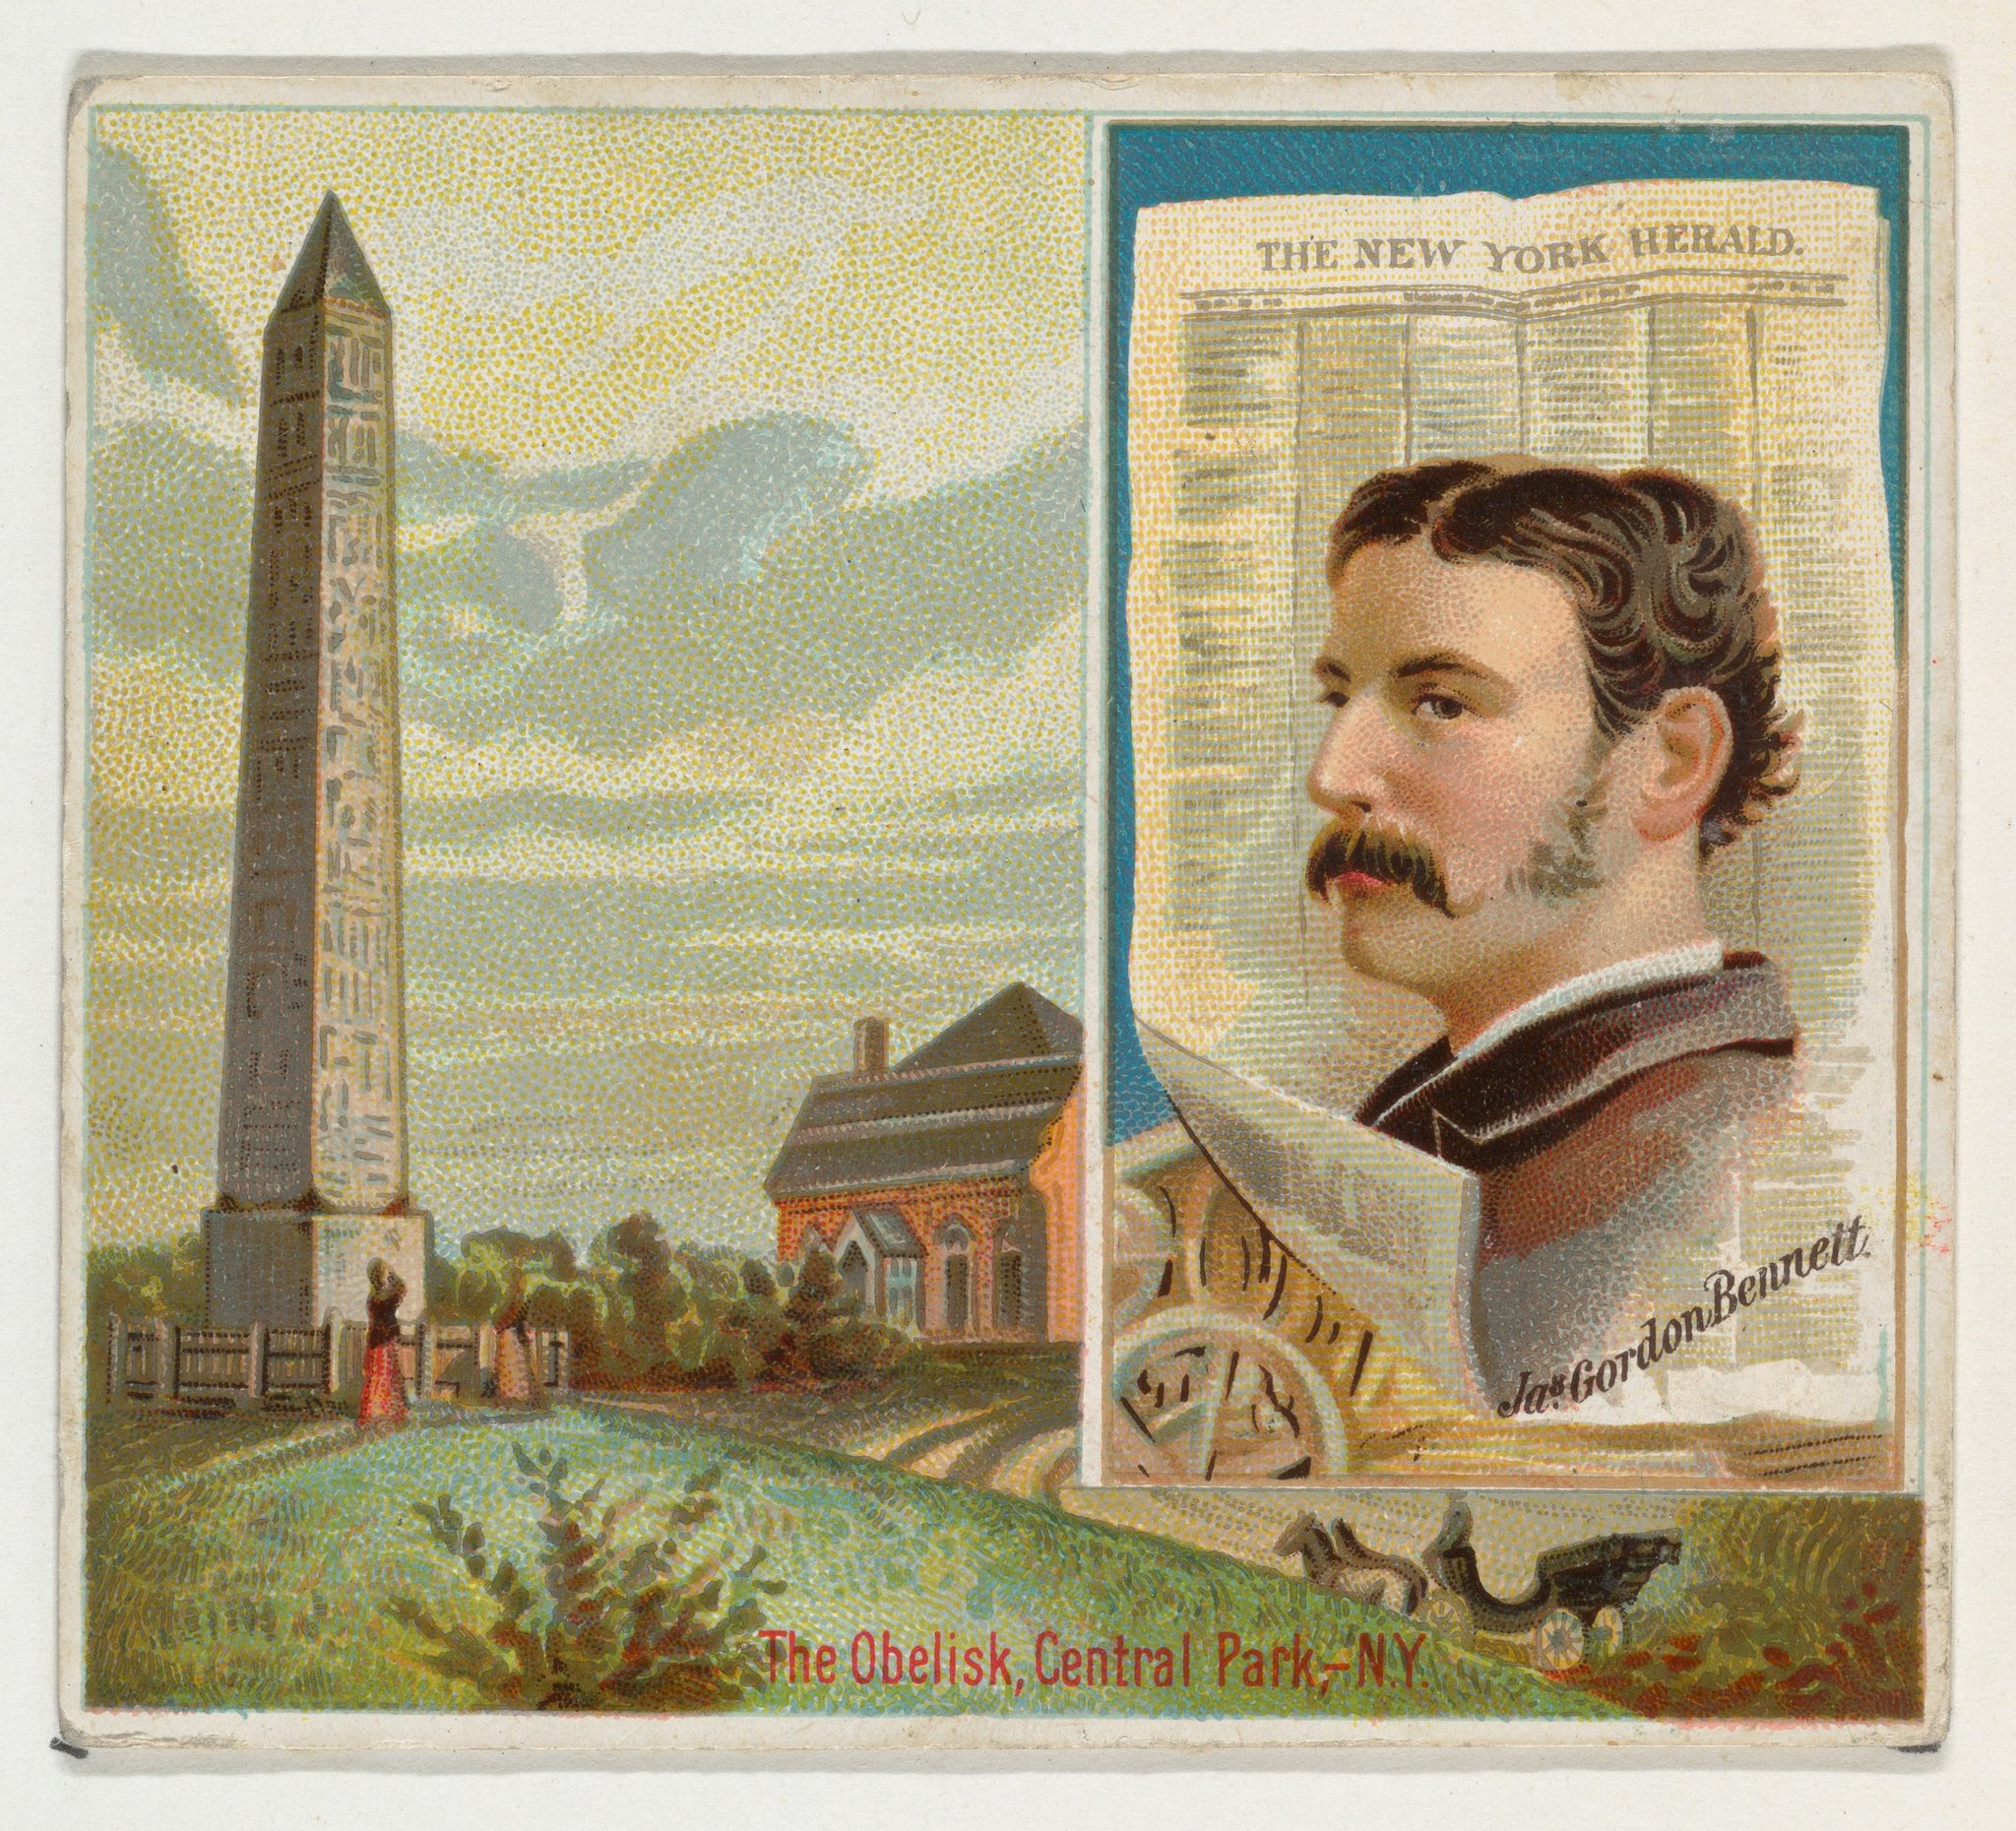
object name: print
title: James Gordon Bennett, The New York Herald, from the American Editors series (N35) for Allen & Ginter Cigarettes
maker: allen & ginter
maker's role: publisher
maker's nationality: american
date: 1887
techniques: color lithograph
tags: obelisks,men